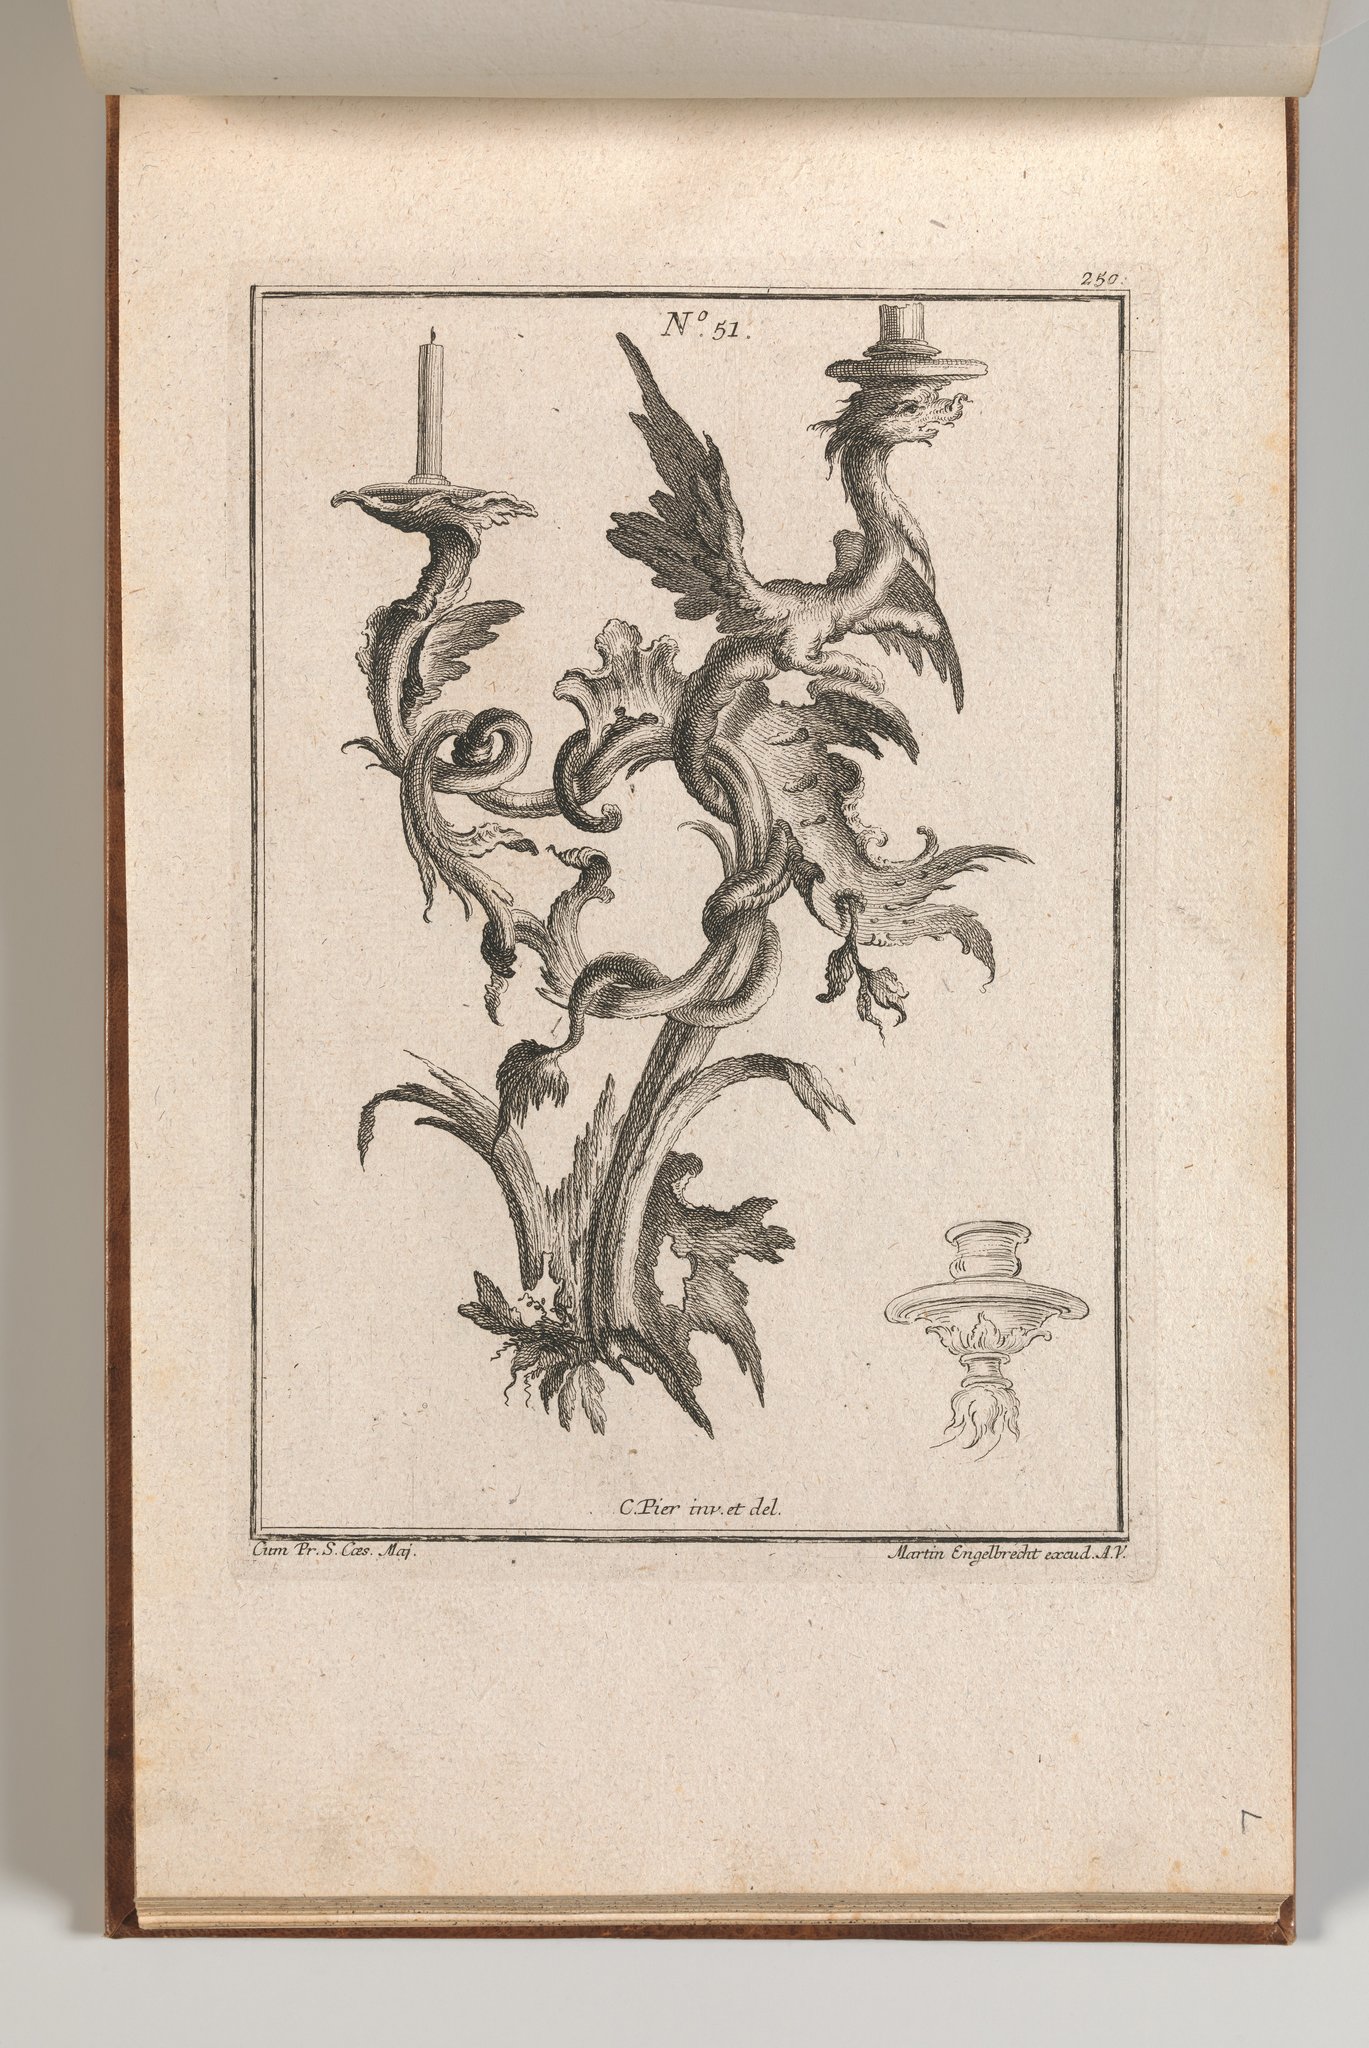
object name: album print ornament architecture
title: Design for a Two-Armed Candelabra with a Dragon, Plate 1 from an Untitled Series of Designs for Suspended Candelabras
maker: carl pier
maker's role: artist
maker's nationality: german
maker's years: 1700-1790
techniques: etching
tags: dragons,candelabra